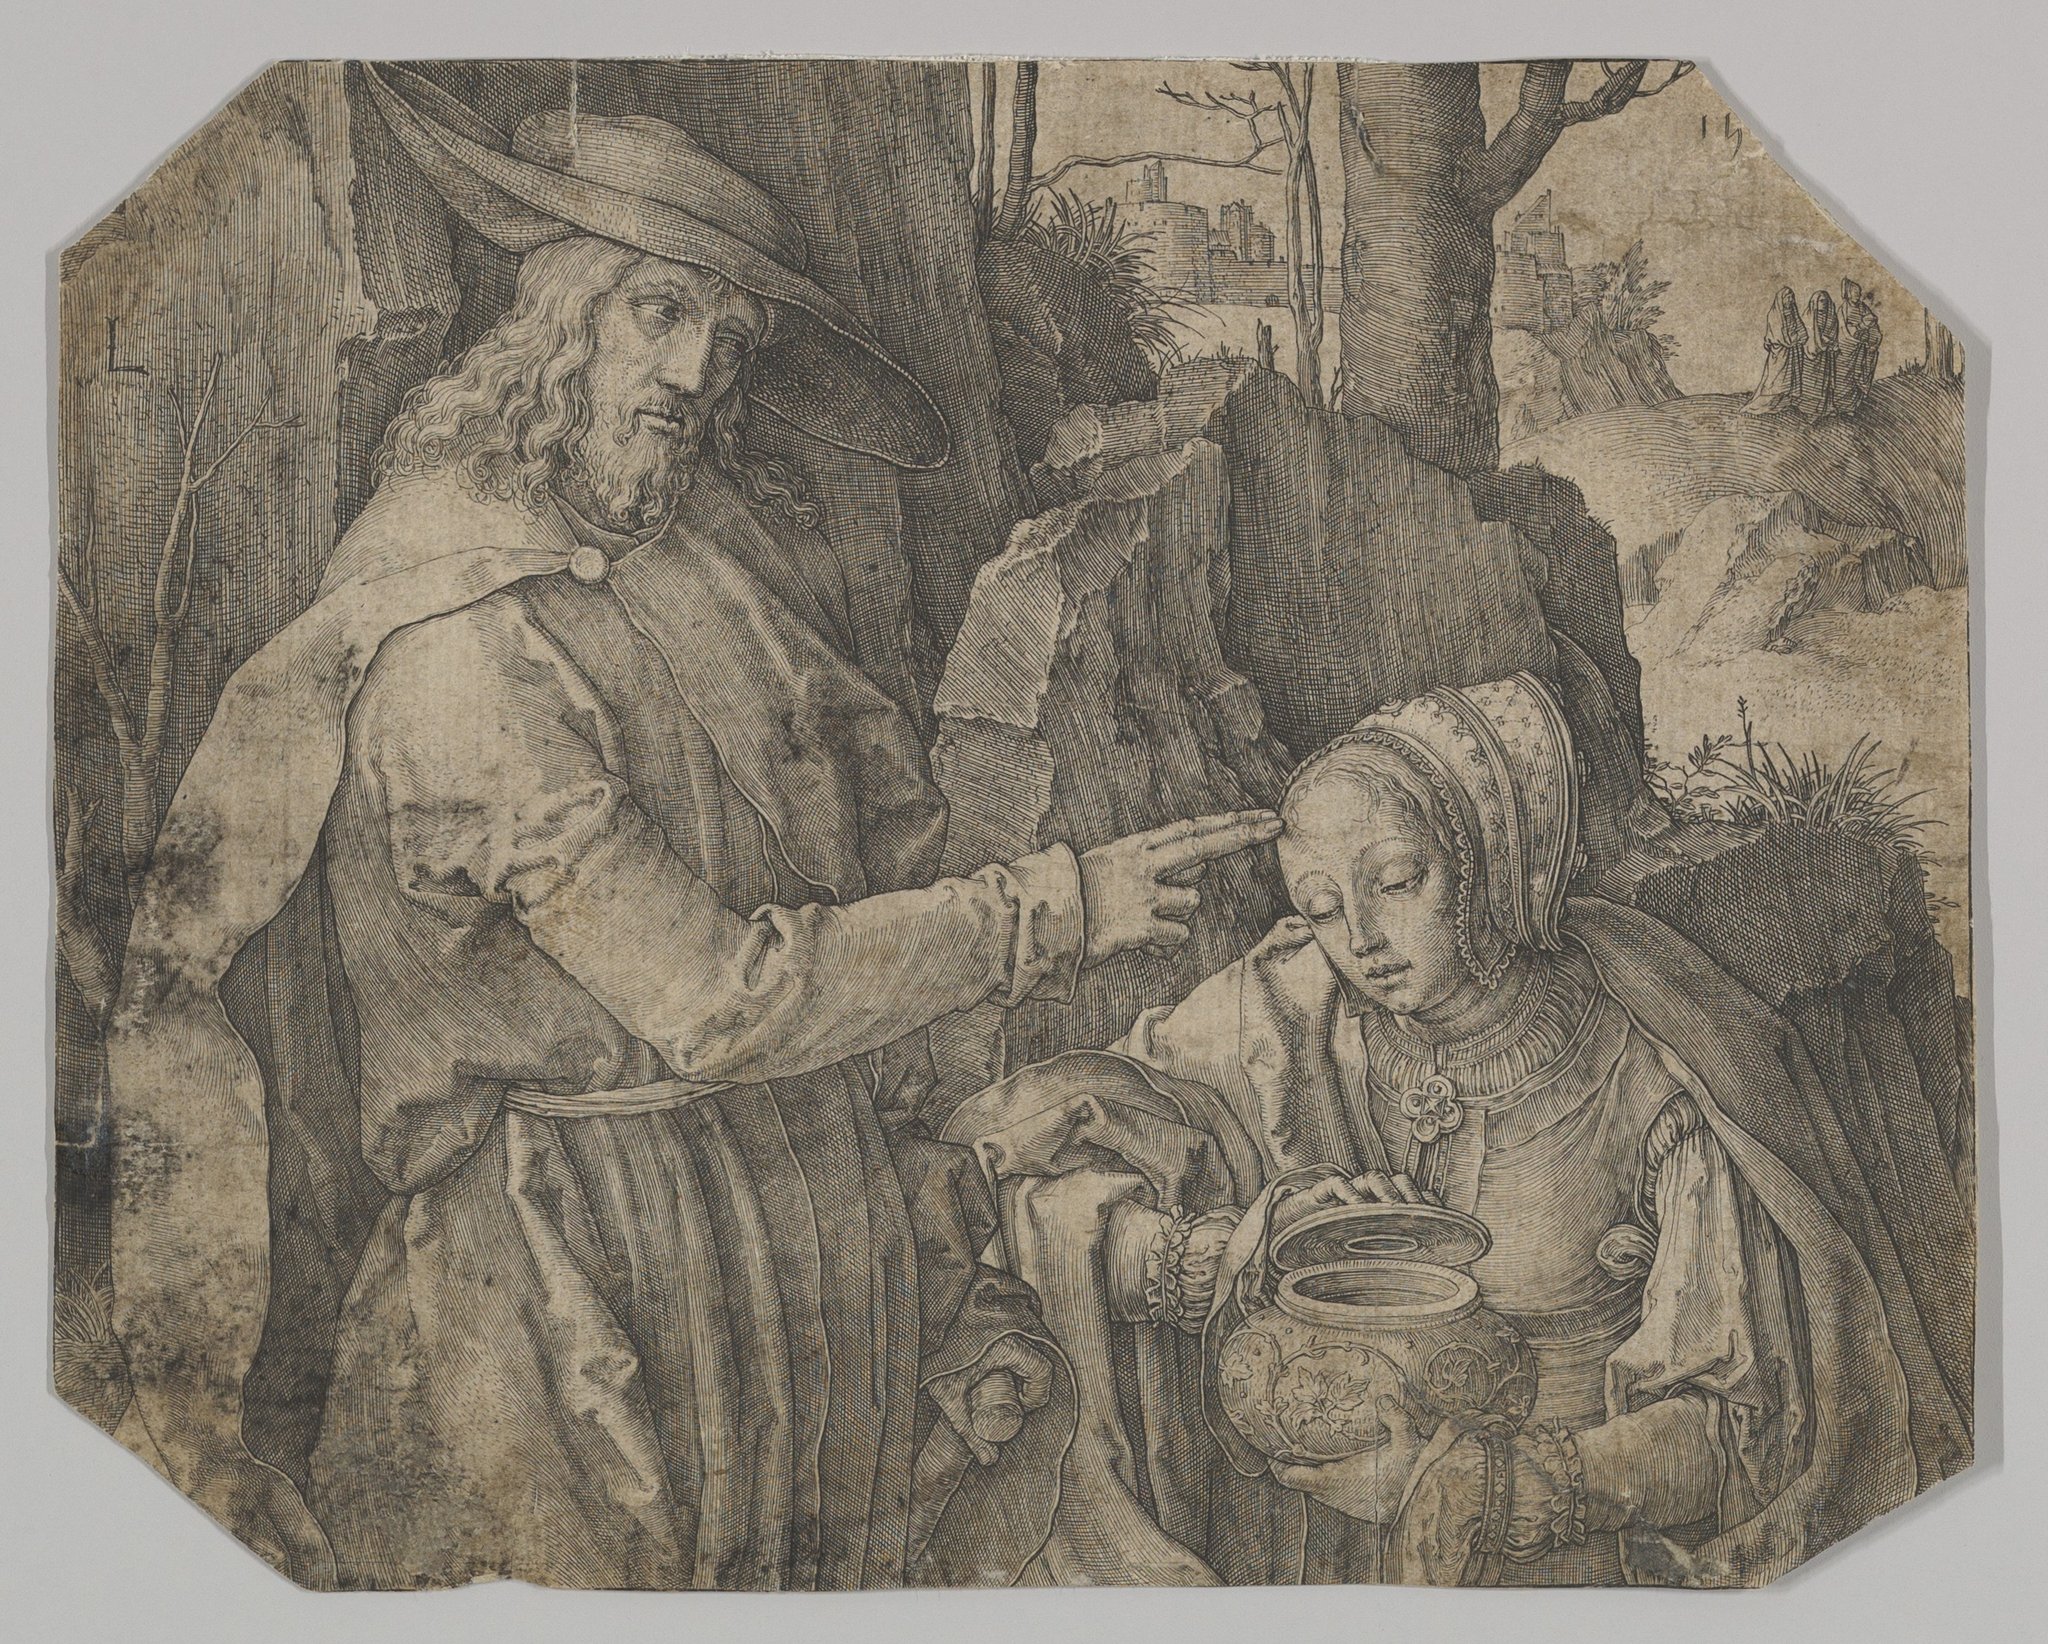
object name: print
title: Christ Appearing to St. Mary Magdalene as a Gardener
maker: lucas van leyden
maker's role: artist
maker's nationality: netherlandish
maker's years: 1494-1533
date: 1519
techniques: engraving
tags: christ,mary magdalene